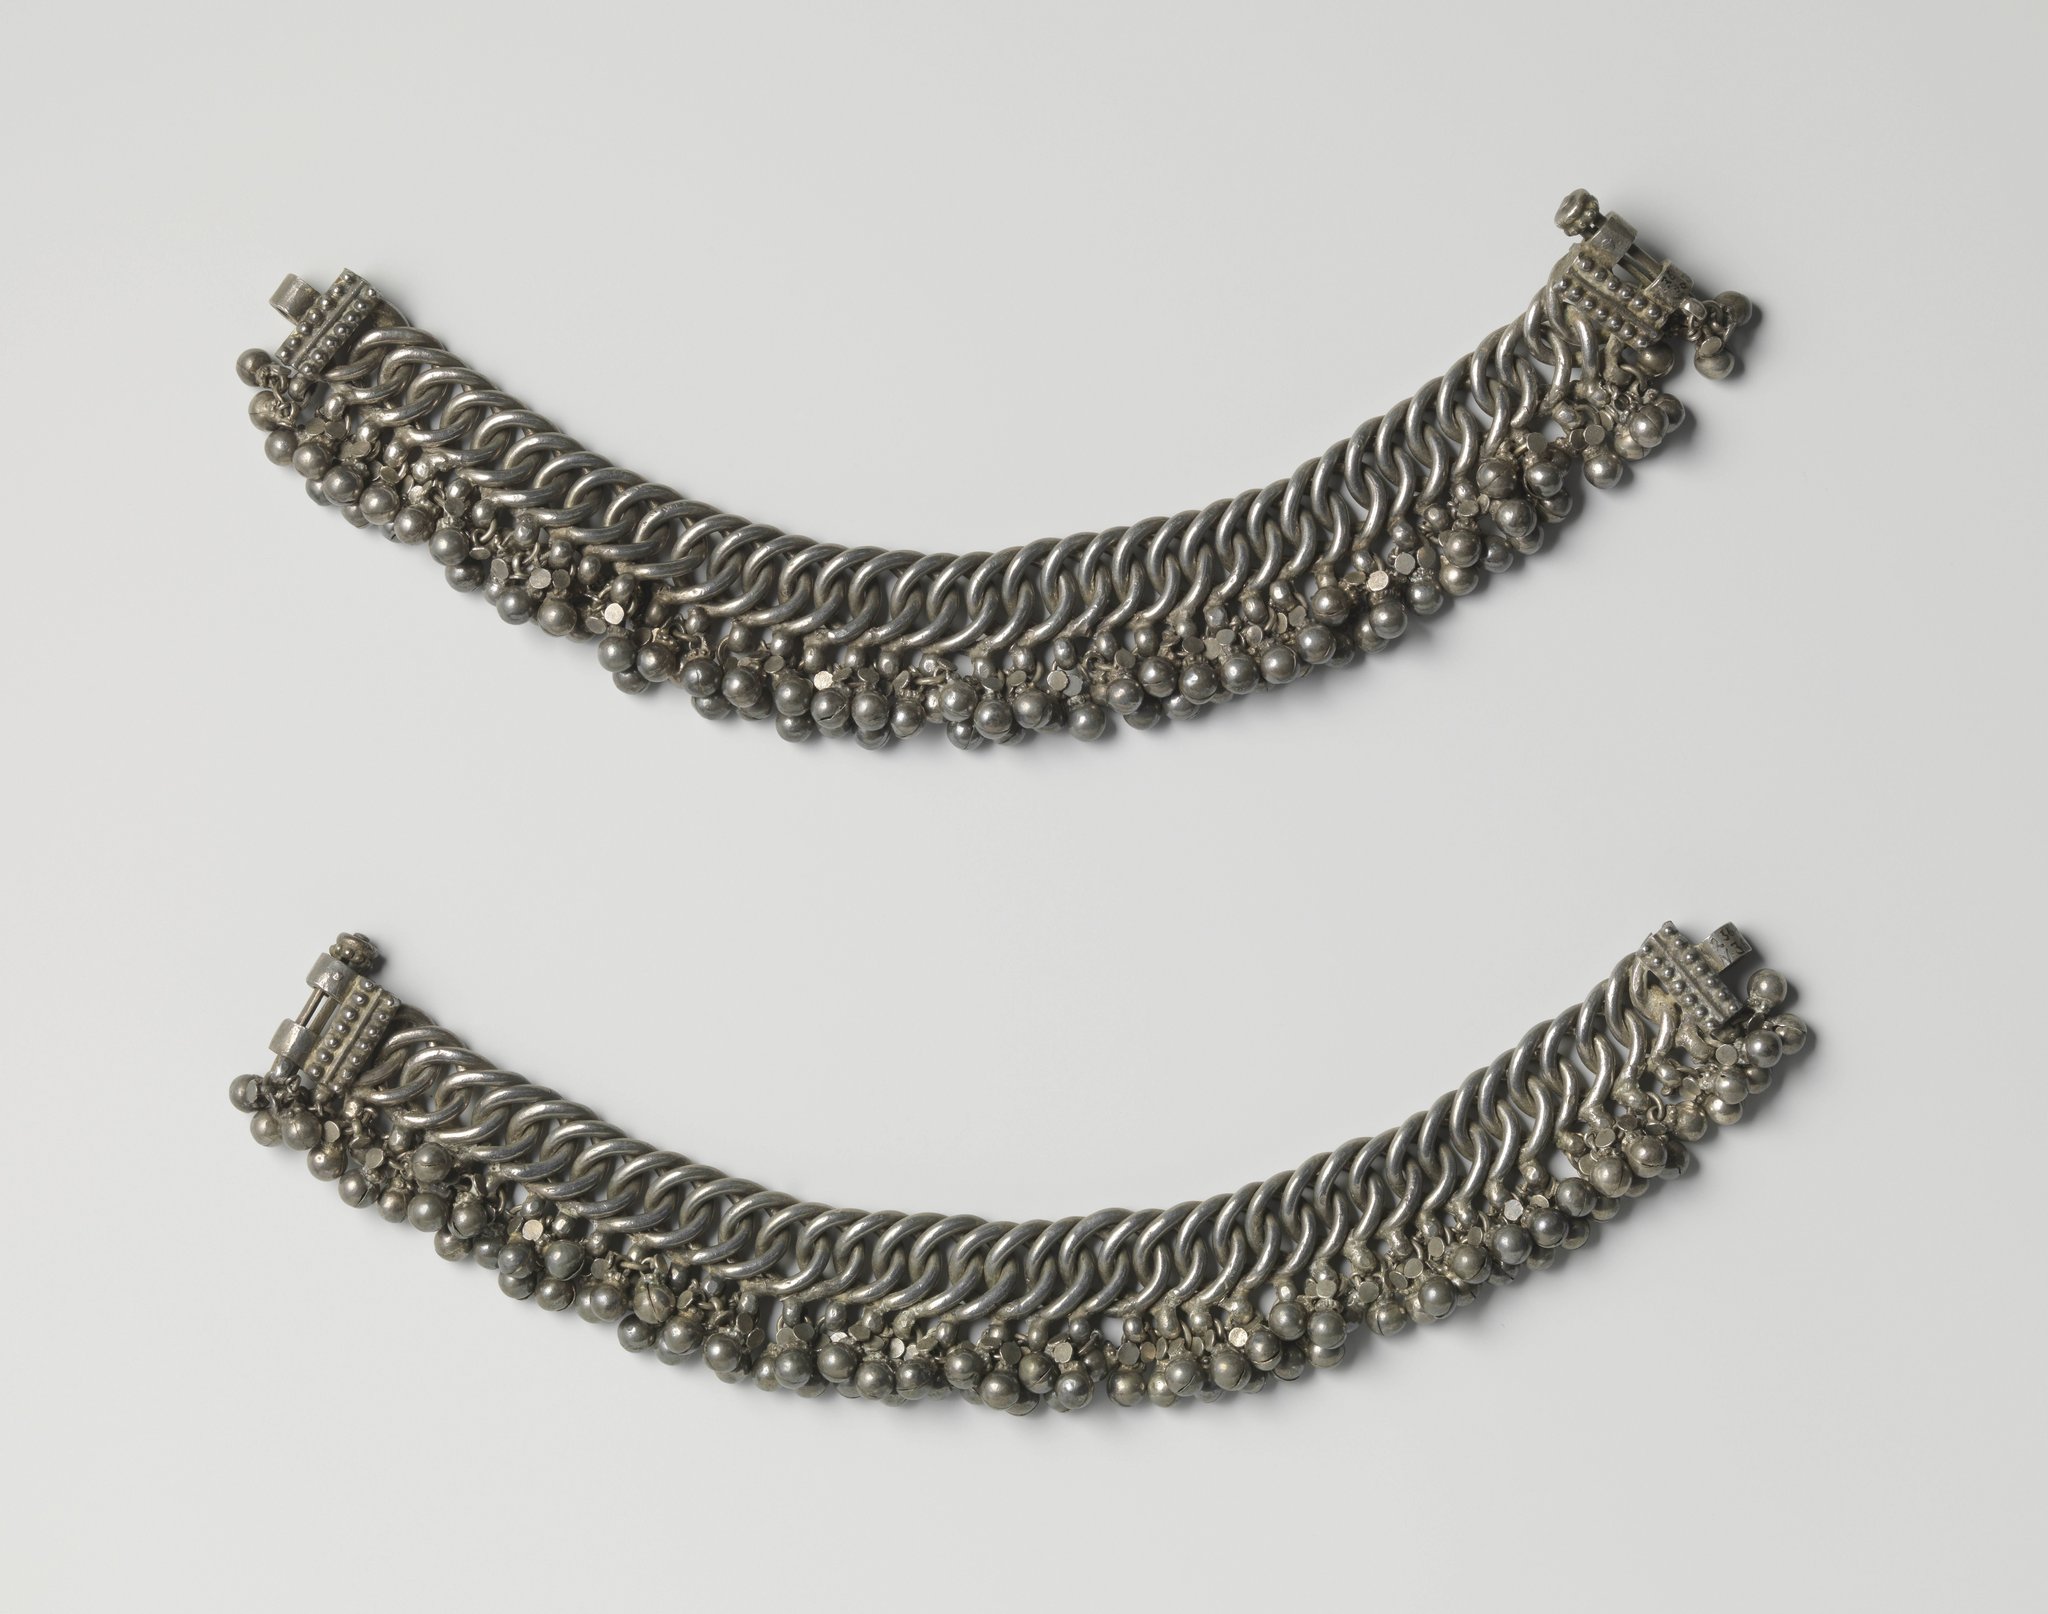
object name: jewellery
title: Pair of anklets (paizel)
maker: Anonymous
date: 1750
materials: silver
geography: surat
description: Een paar enkelbanden (paizel) van zilver. Bestaande uit gevlochten schakels waaraan kleine zilveren belletjes hangen. Met scharniersluiting.